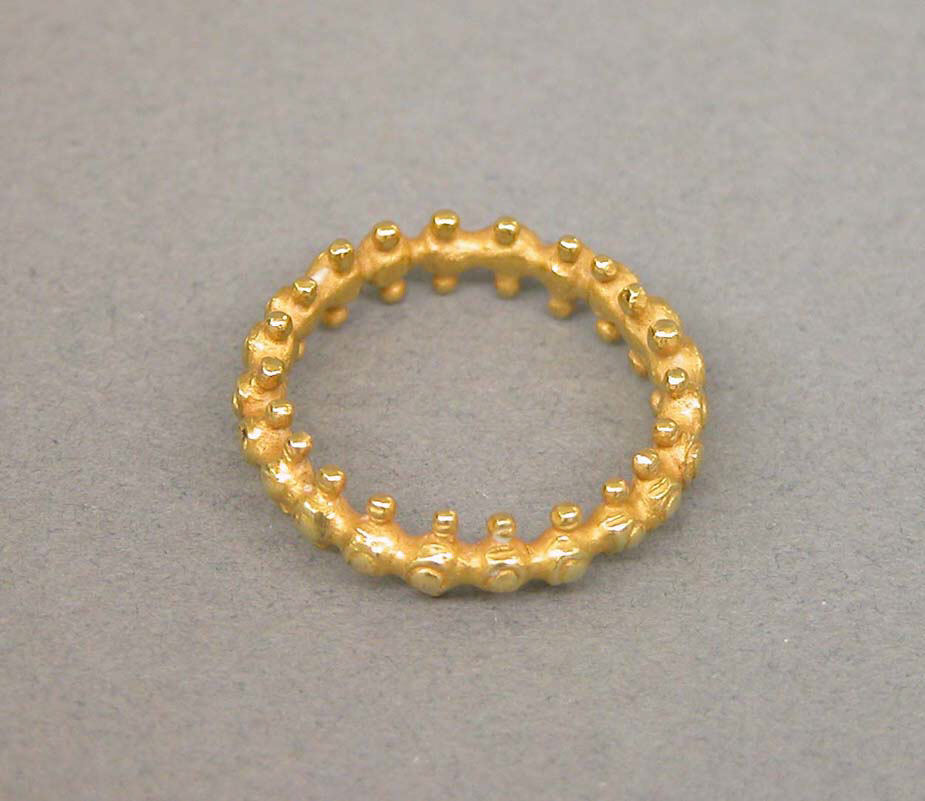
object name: ring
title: Ring Composed of Continuous Keben Fruit Motifs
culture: indonesian, javanese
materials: gold